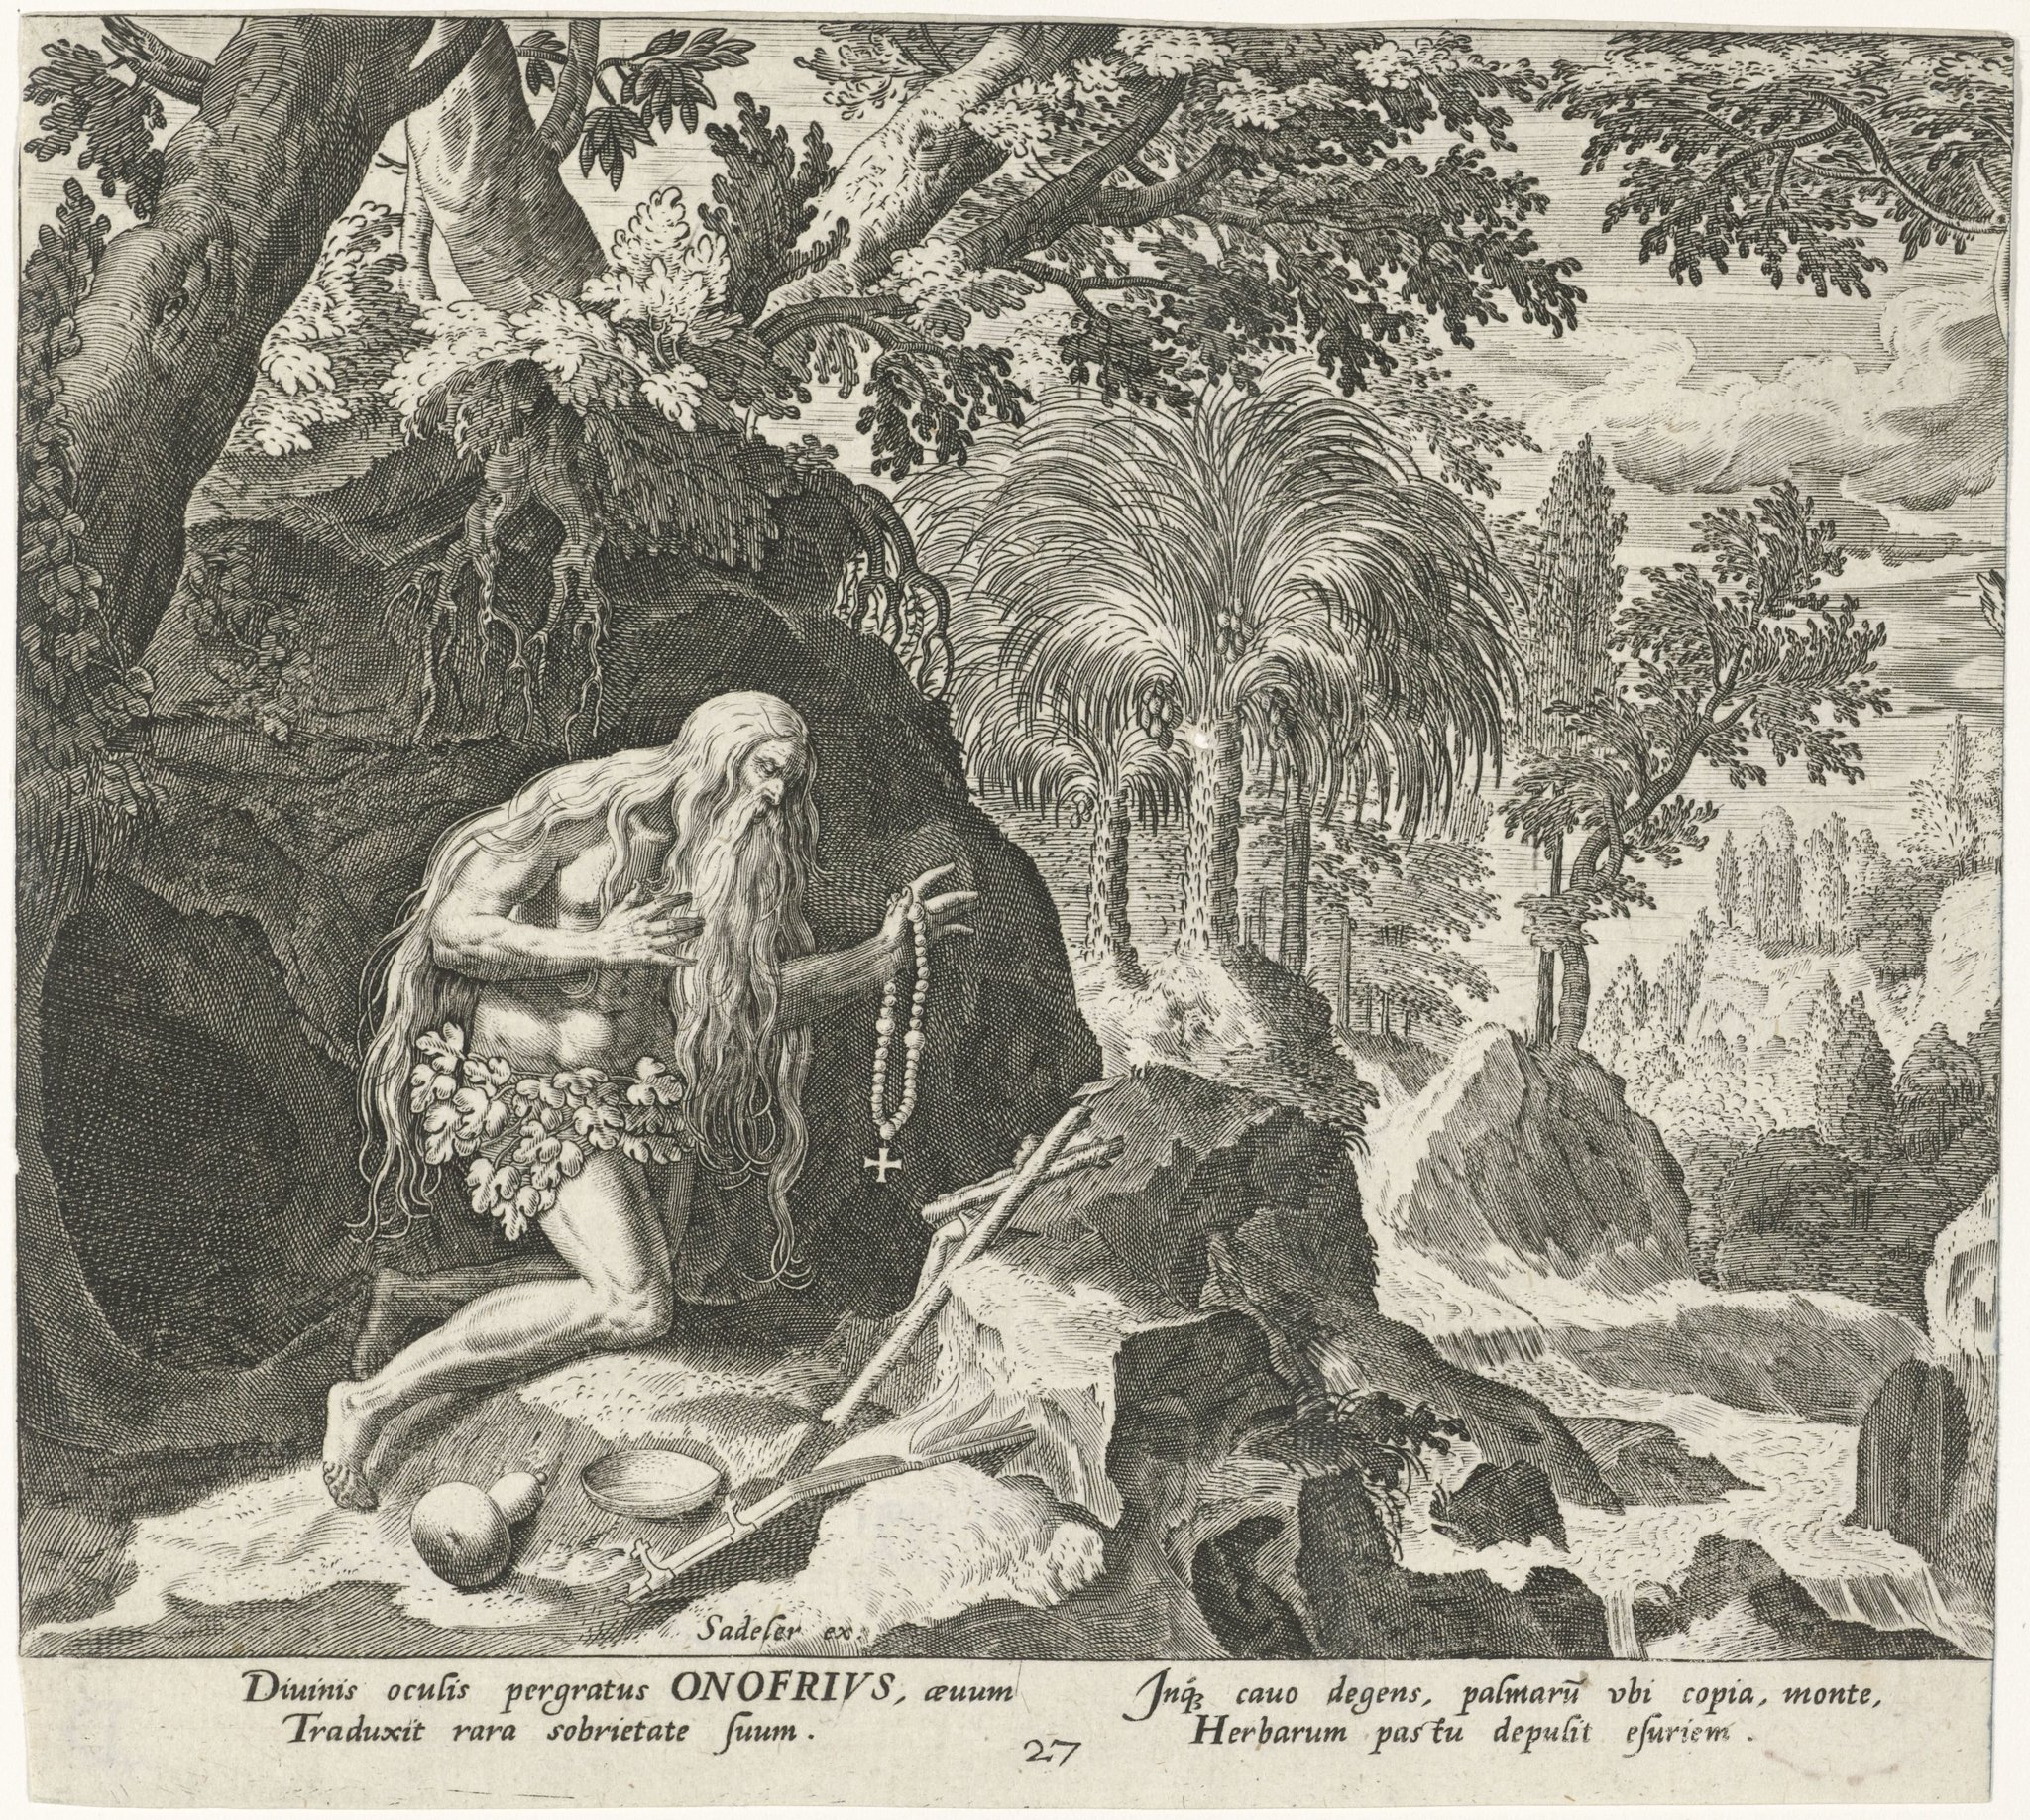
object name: print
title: Mannelijke kluizenaars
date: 1583-1588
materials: paper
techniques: engraving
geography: antwerp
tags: waterfall, the hermit onuphrius; possible attributes: chalice and host, cross, crown (or coins), at his feet, raven, two lions, anchorite, hermit, cave, grotto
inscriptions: collector's mark: Lugt 240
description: De H. Onyphrius de Grote als kluizenaar voor een grot in de wildernis. Hij draagt een lendegordel van bladeren en zit geknield de rozenkrans te bidden.